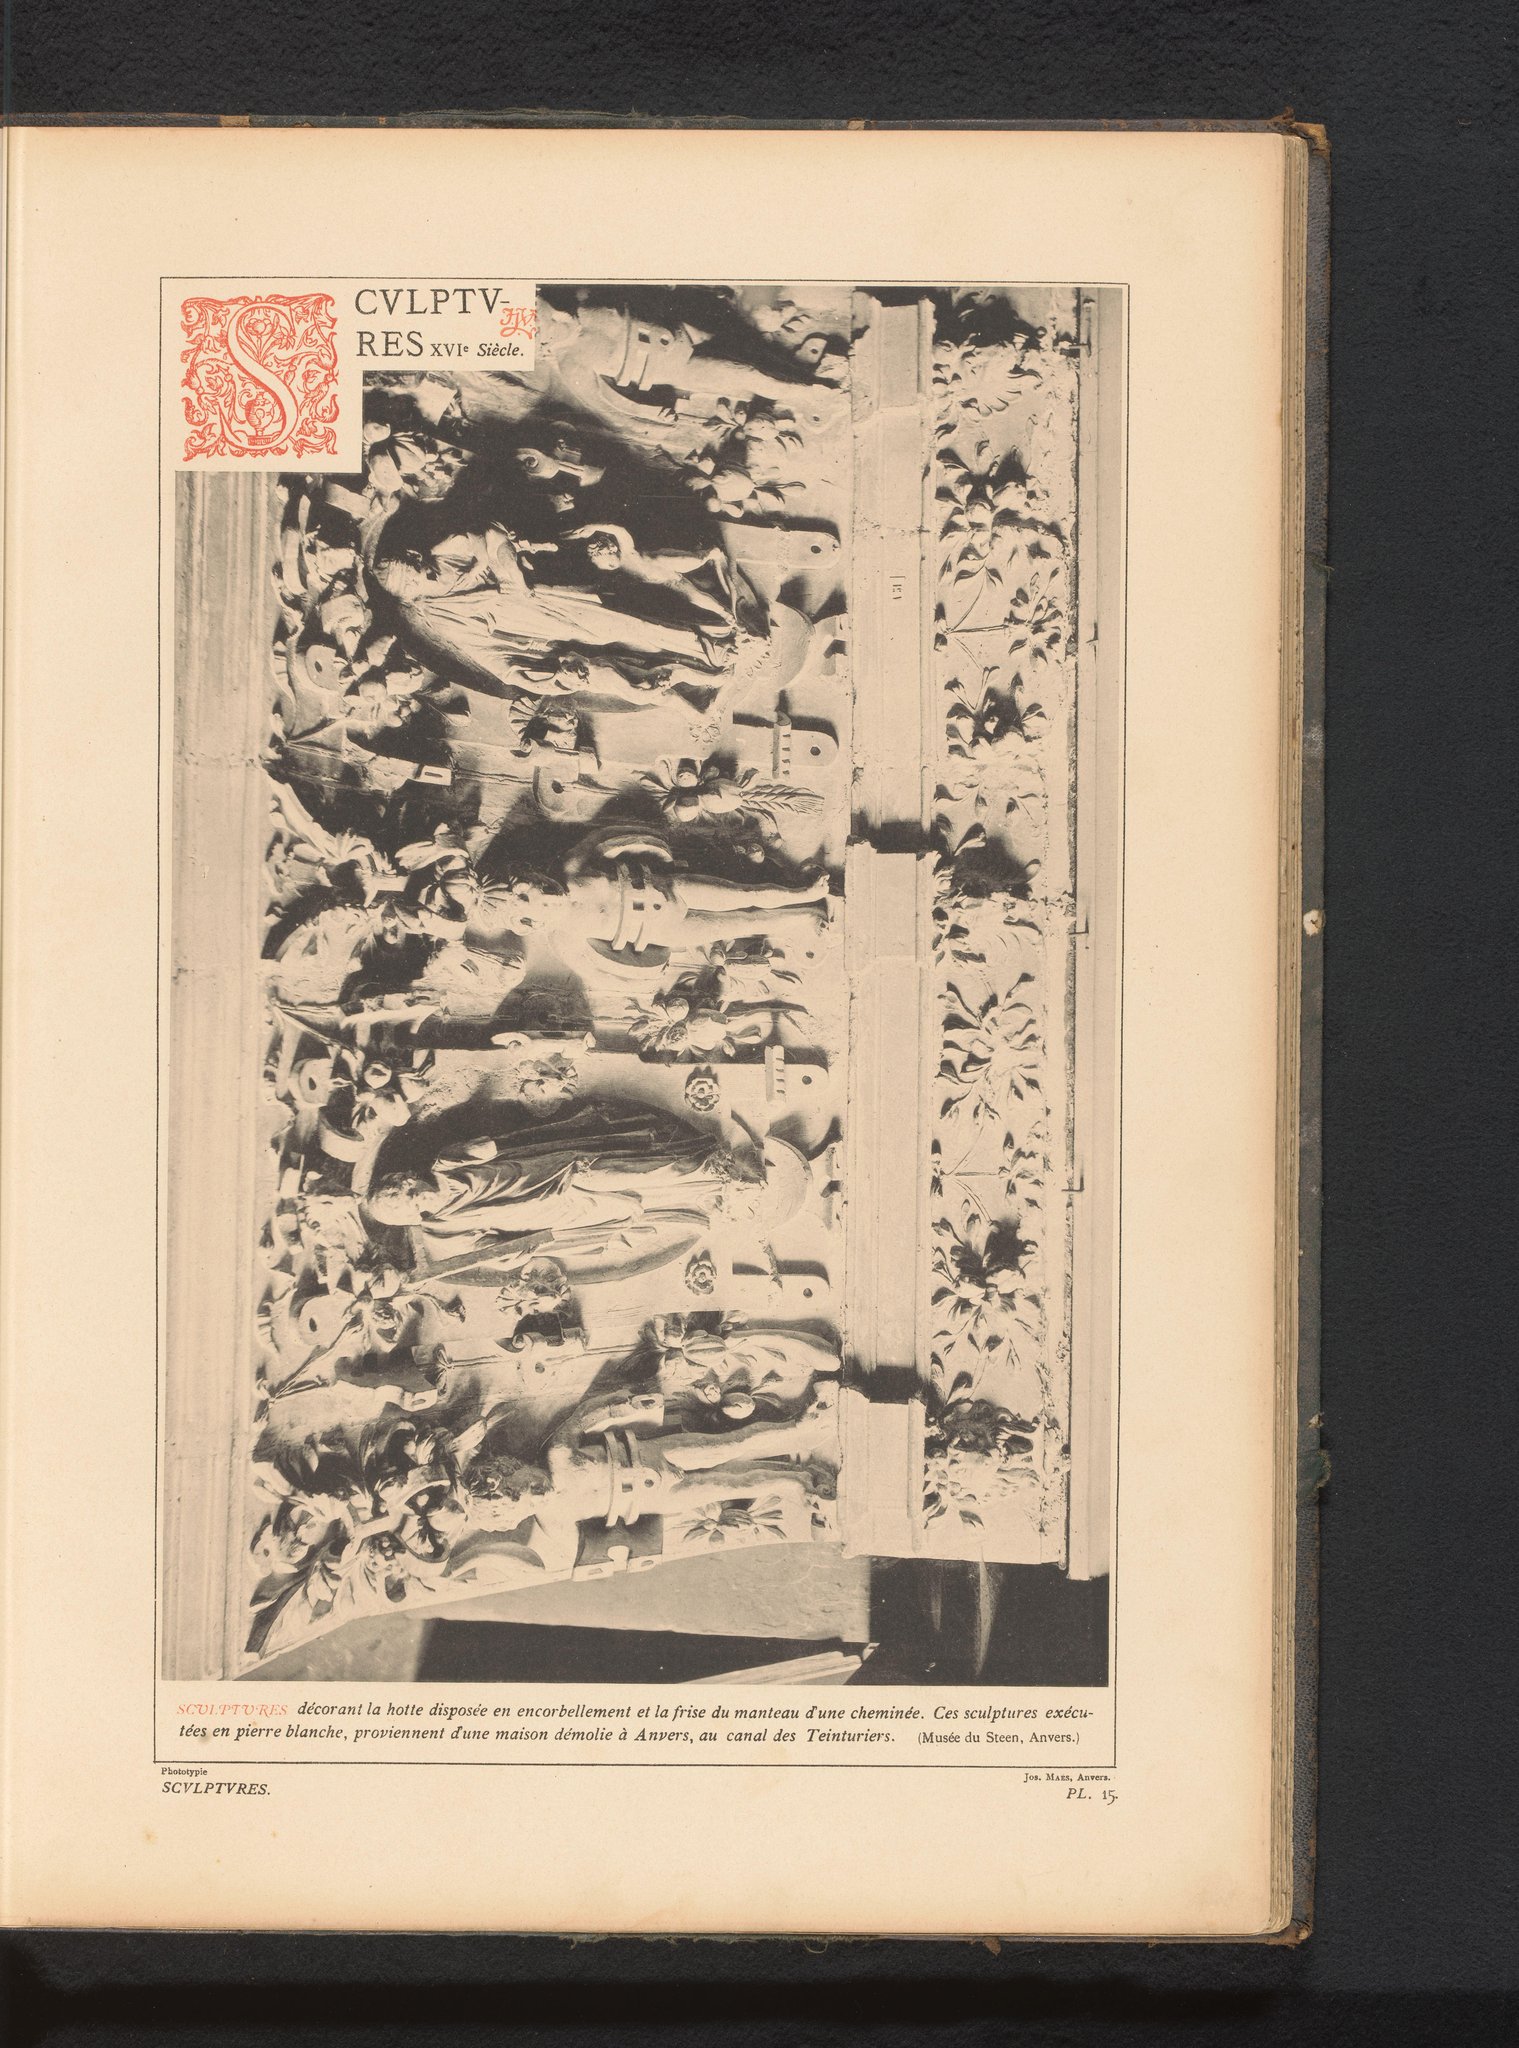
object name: page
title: Deel van een gedecoreerde schoorsteenmantel in een huis in Antwerpen, België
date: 1882-1887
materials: paper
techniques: photograph, photolithography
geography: antwerp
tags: chimney-piece, mantelpiece, sculpture (+ relief ~ sculpture), antwerp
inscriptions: monogram: ‘JJvY’, inscription: ‘SCULPTURES décorant la (...)’, inscription: ‘SCULPTURES. - PL. 15.’